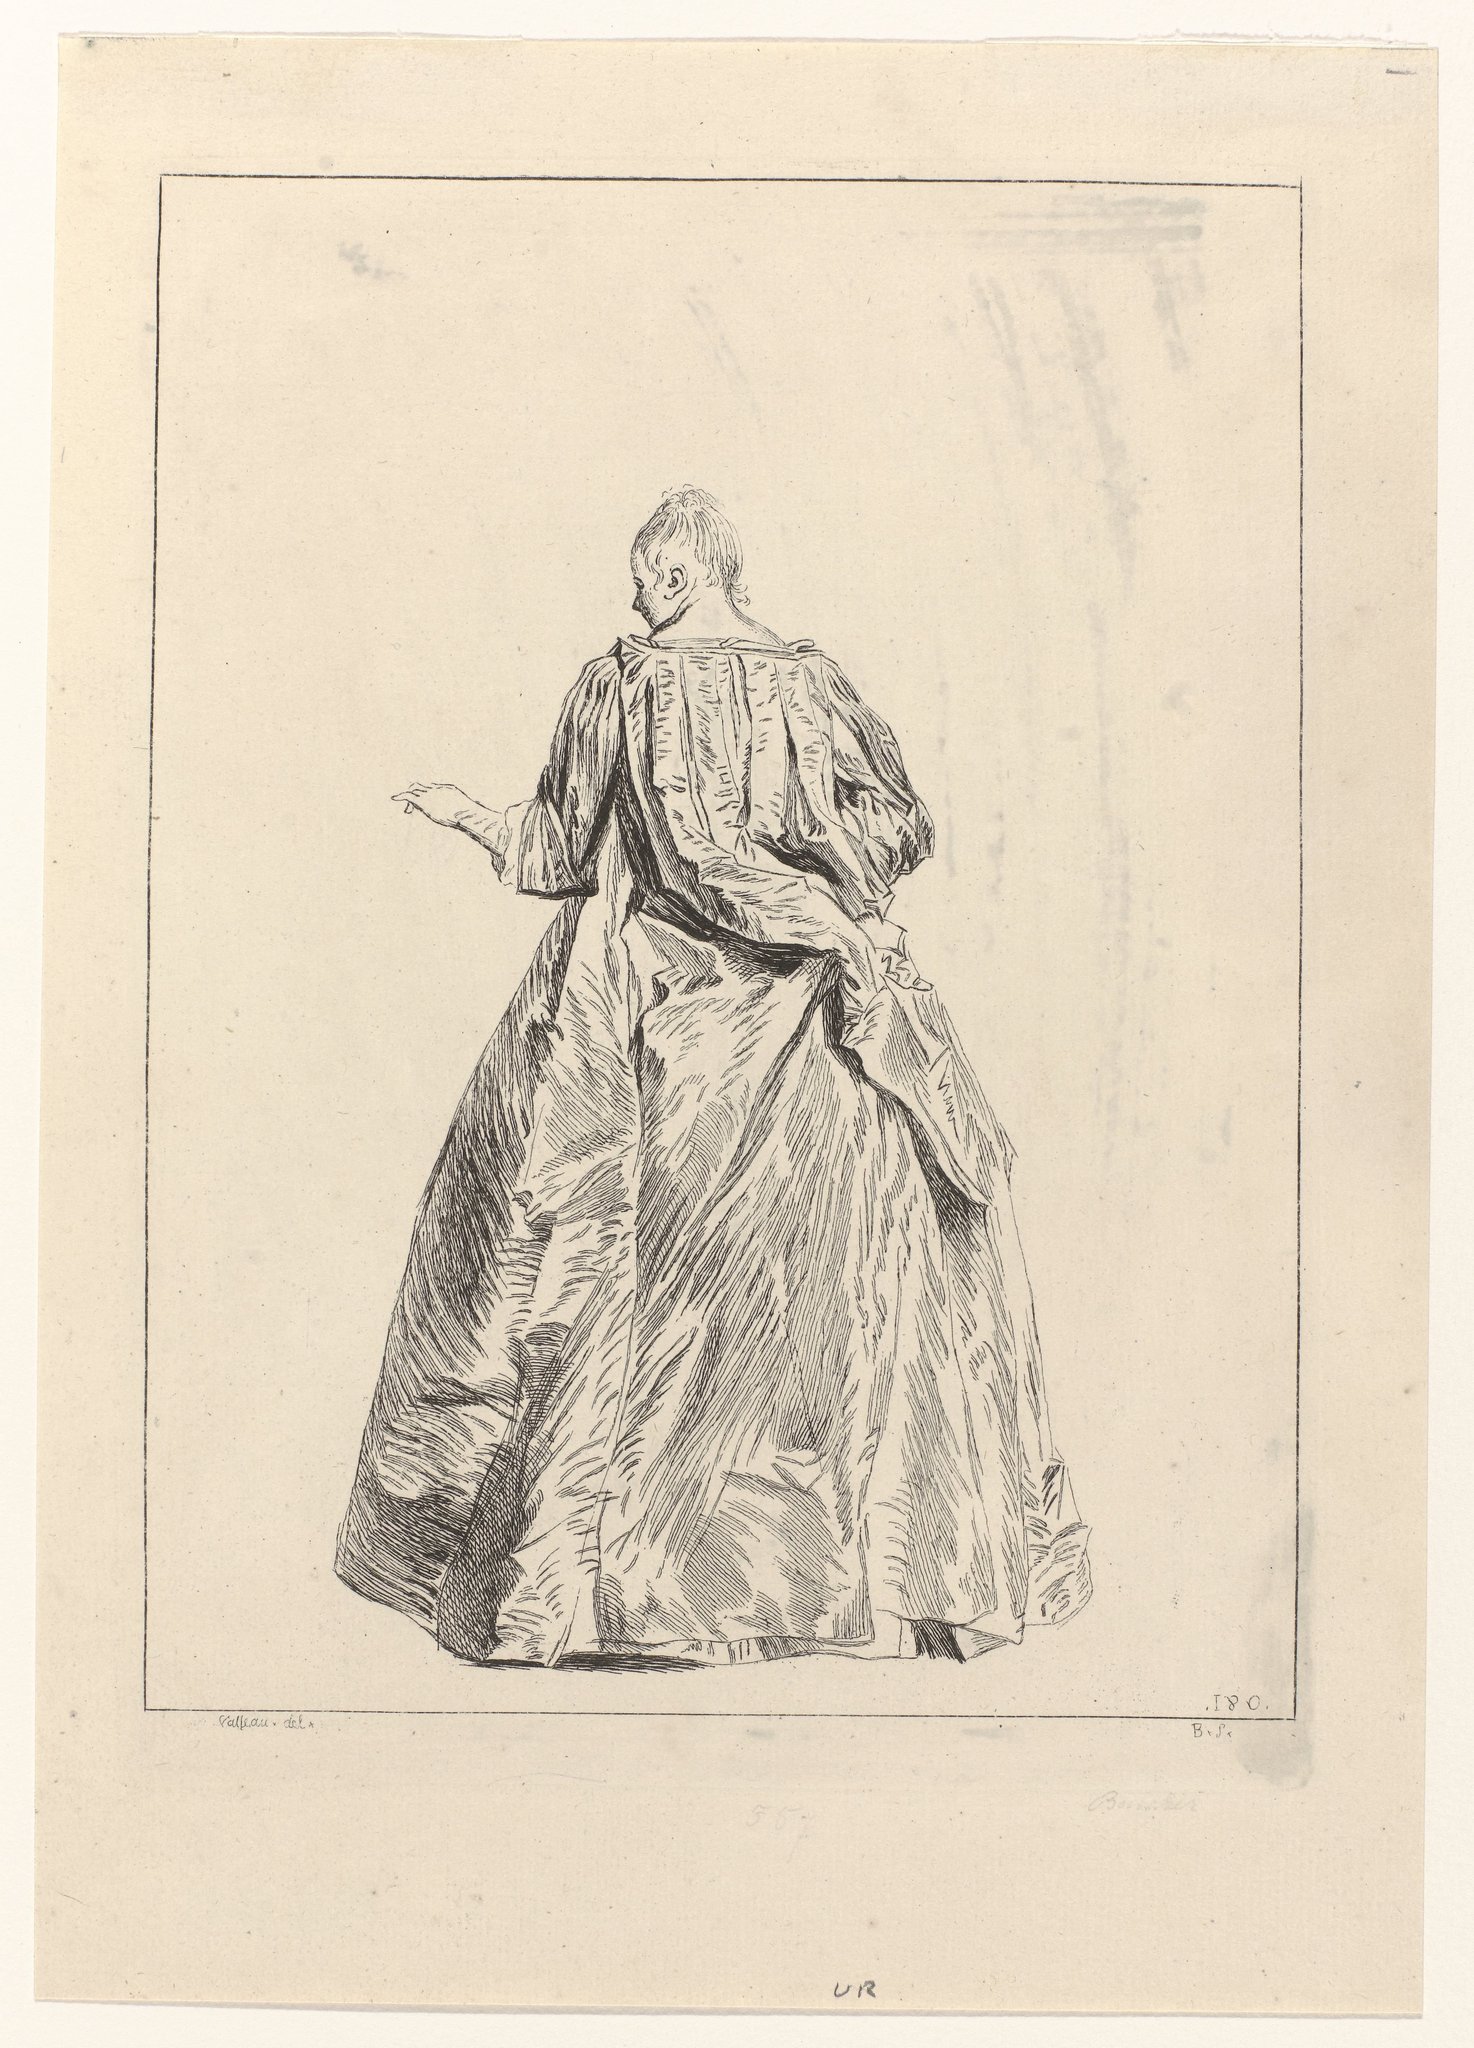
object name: costume print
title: Figures de différents caractères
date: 1728-1770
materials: paper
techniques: etching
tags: dress, gown: robe volante (+ women's clothes), fashion plates, skirt (+ women's clothes)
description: Staande vrouw, schuin op de rug gezien, gekleed in een sak met op de rug een aantal platte plooien. De prent is een eerste staat van een prent voor de serie kostuumprenten getiteld Figures de différents caractères.